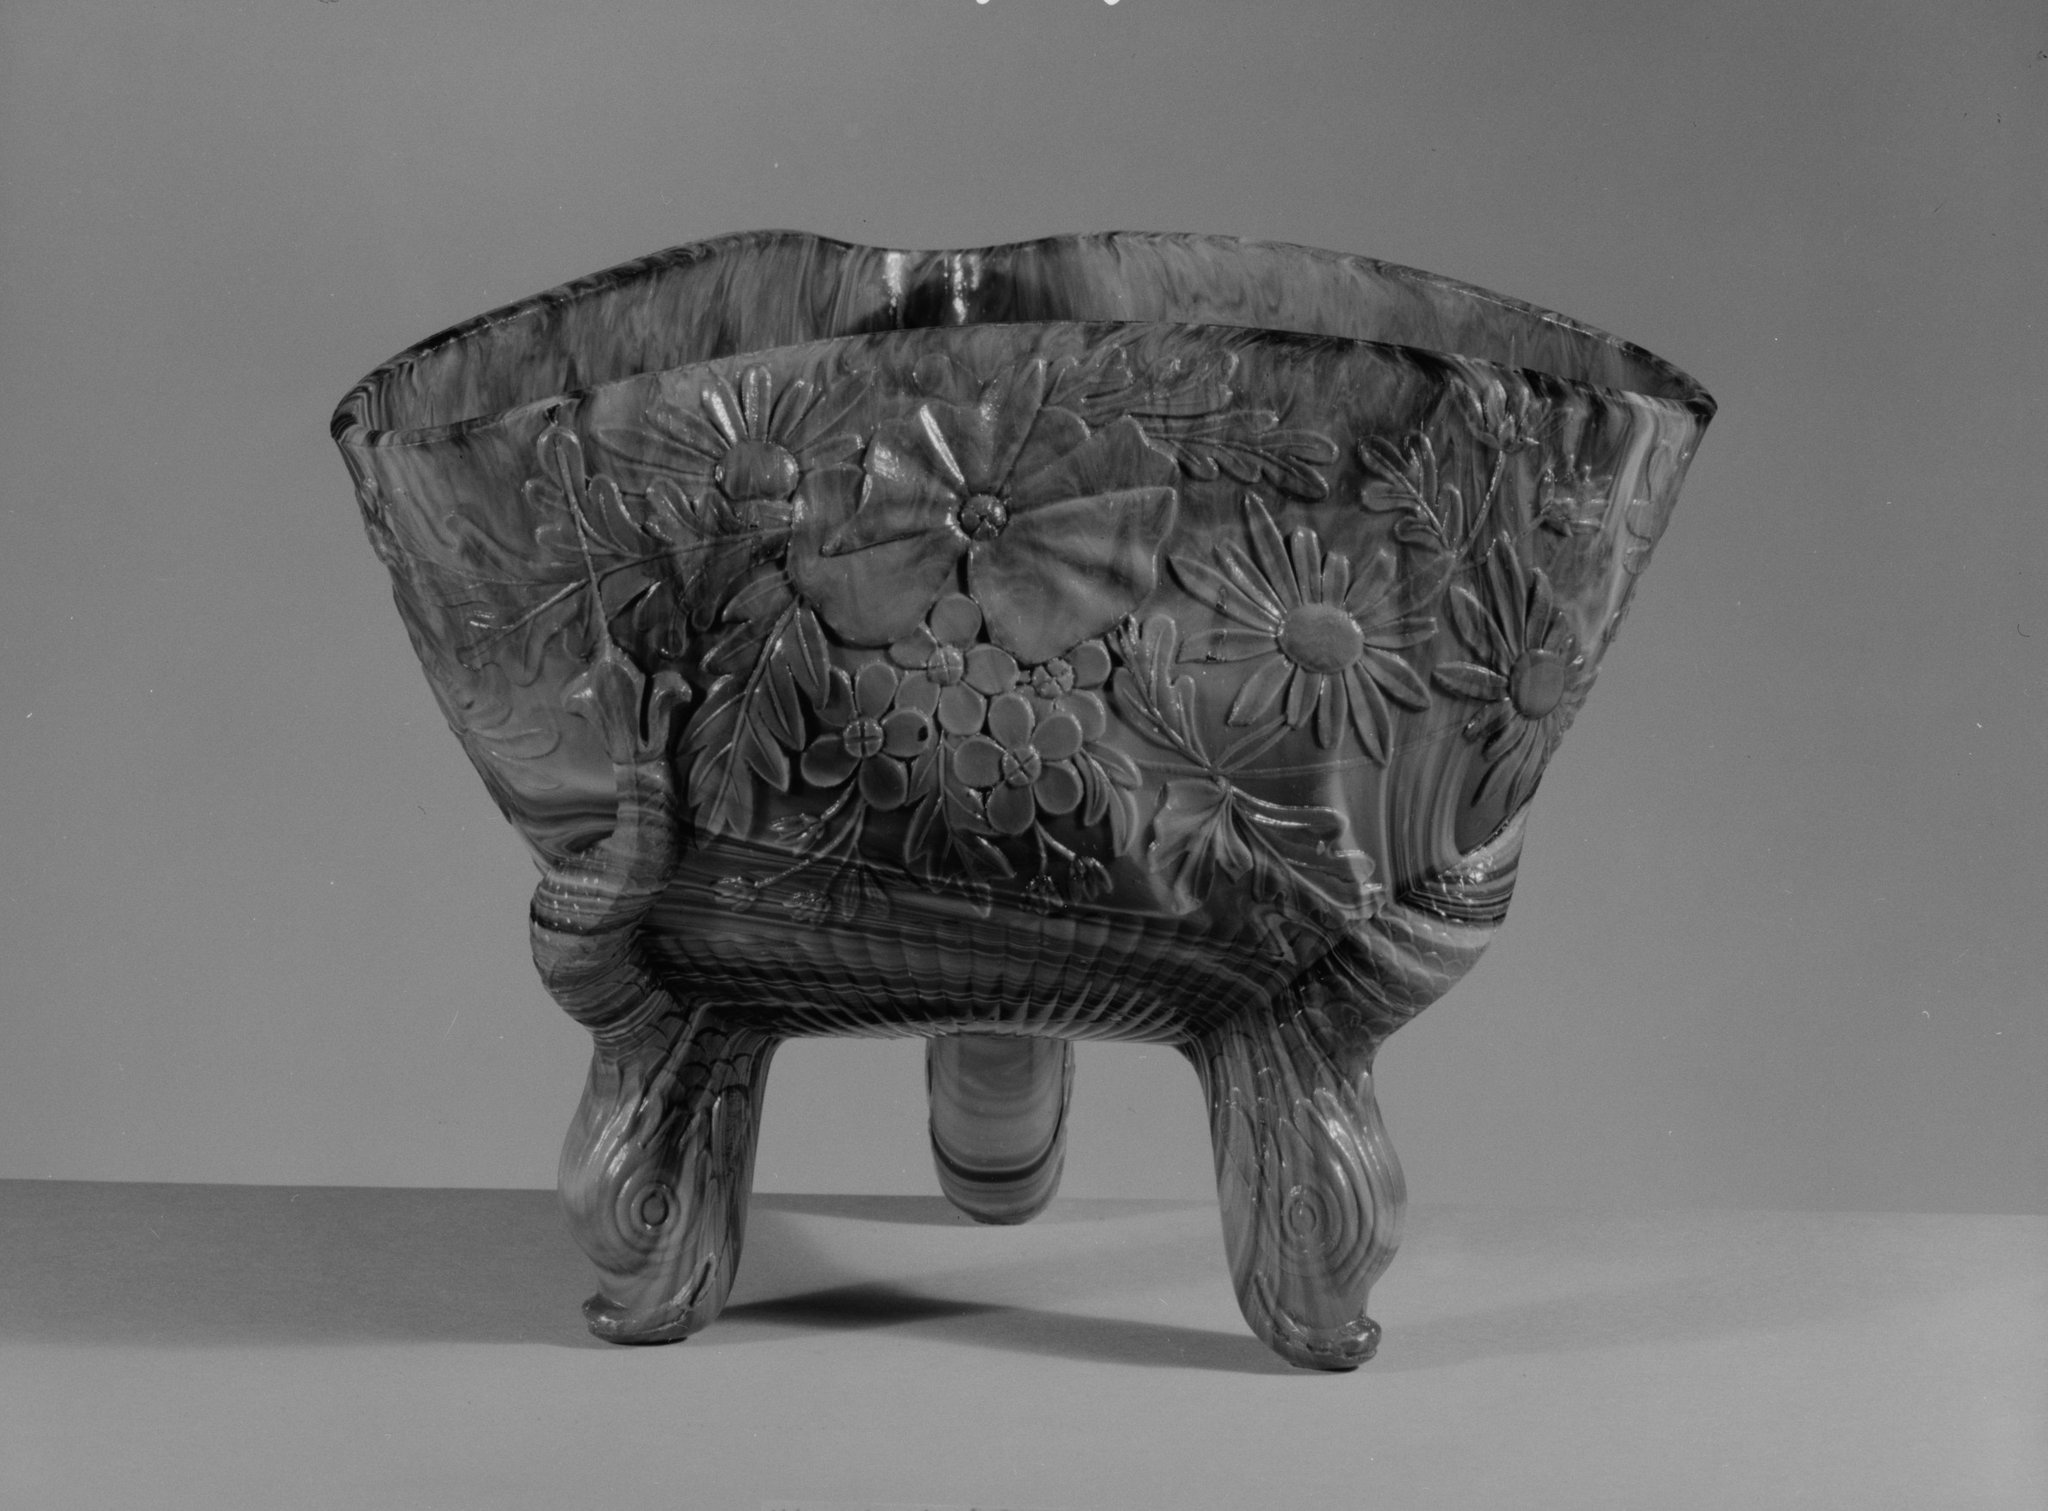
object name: bowl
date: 1880-1890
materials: glass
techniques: pressed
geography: england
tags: flowers